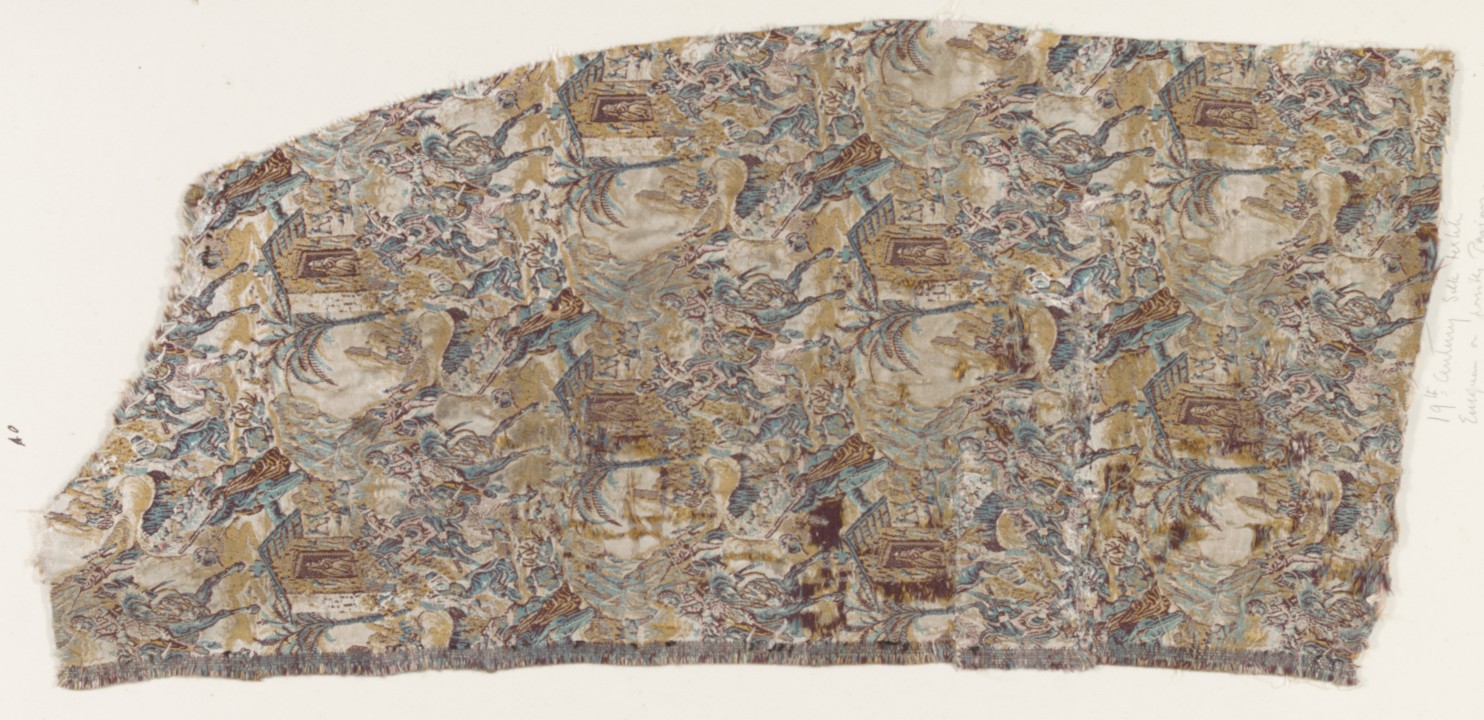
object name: fragment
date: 1801-1900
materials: silk